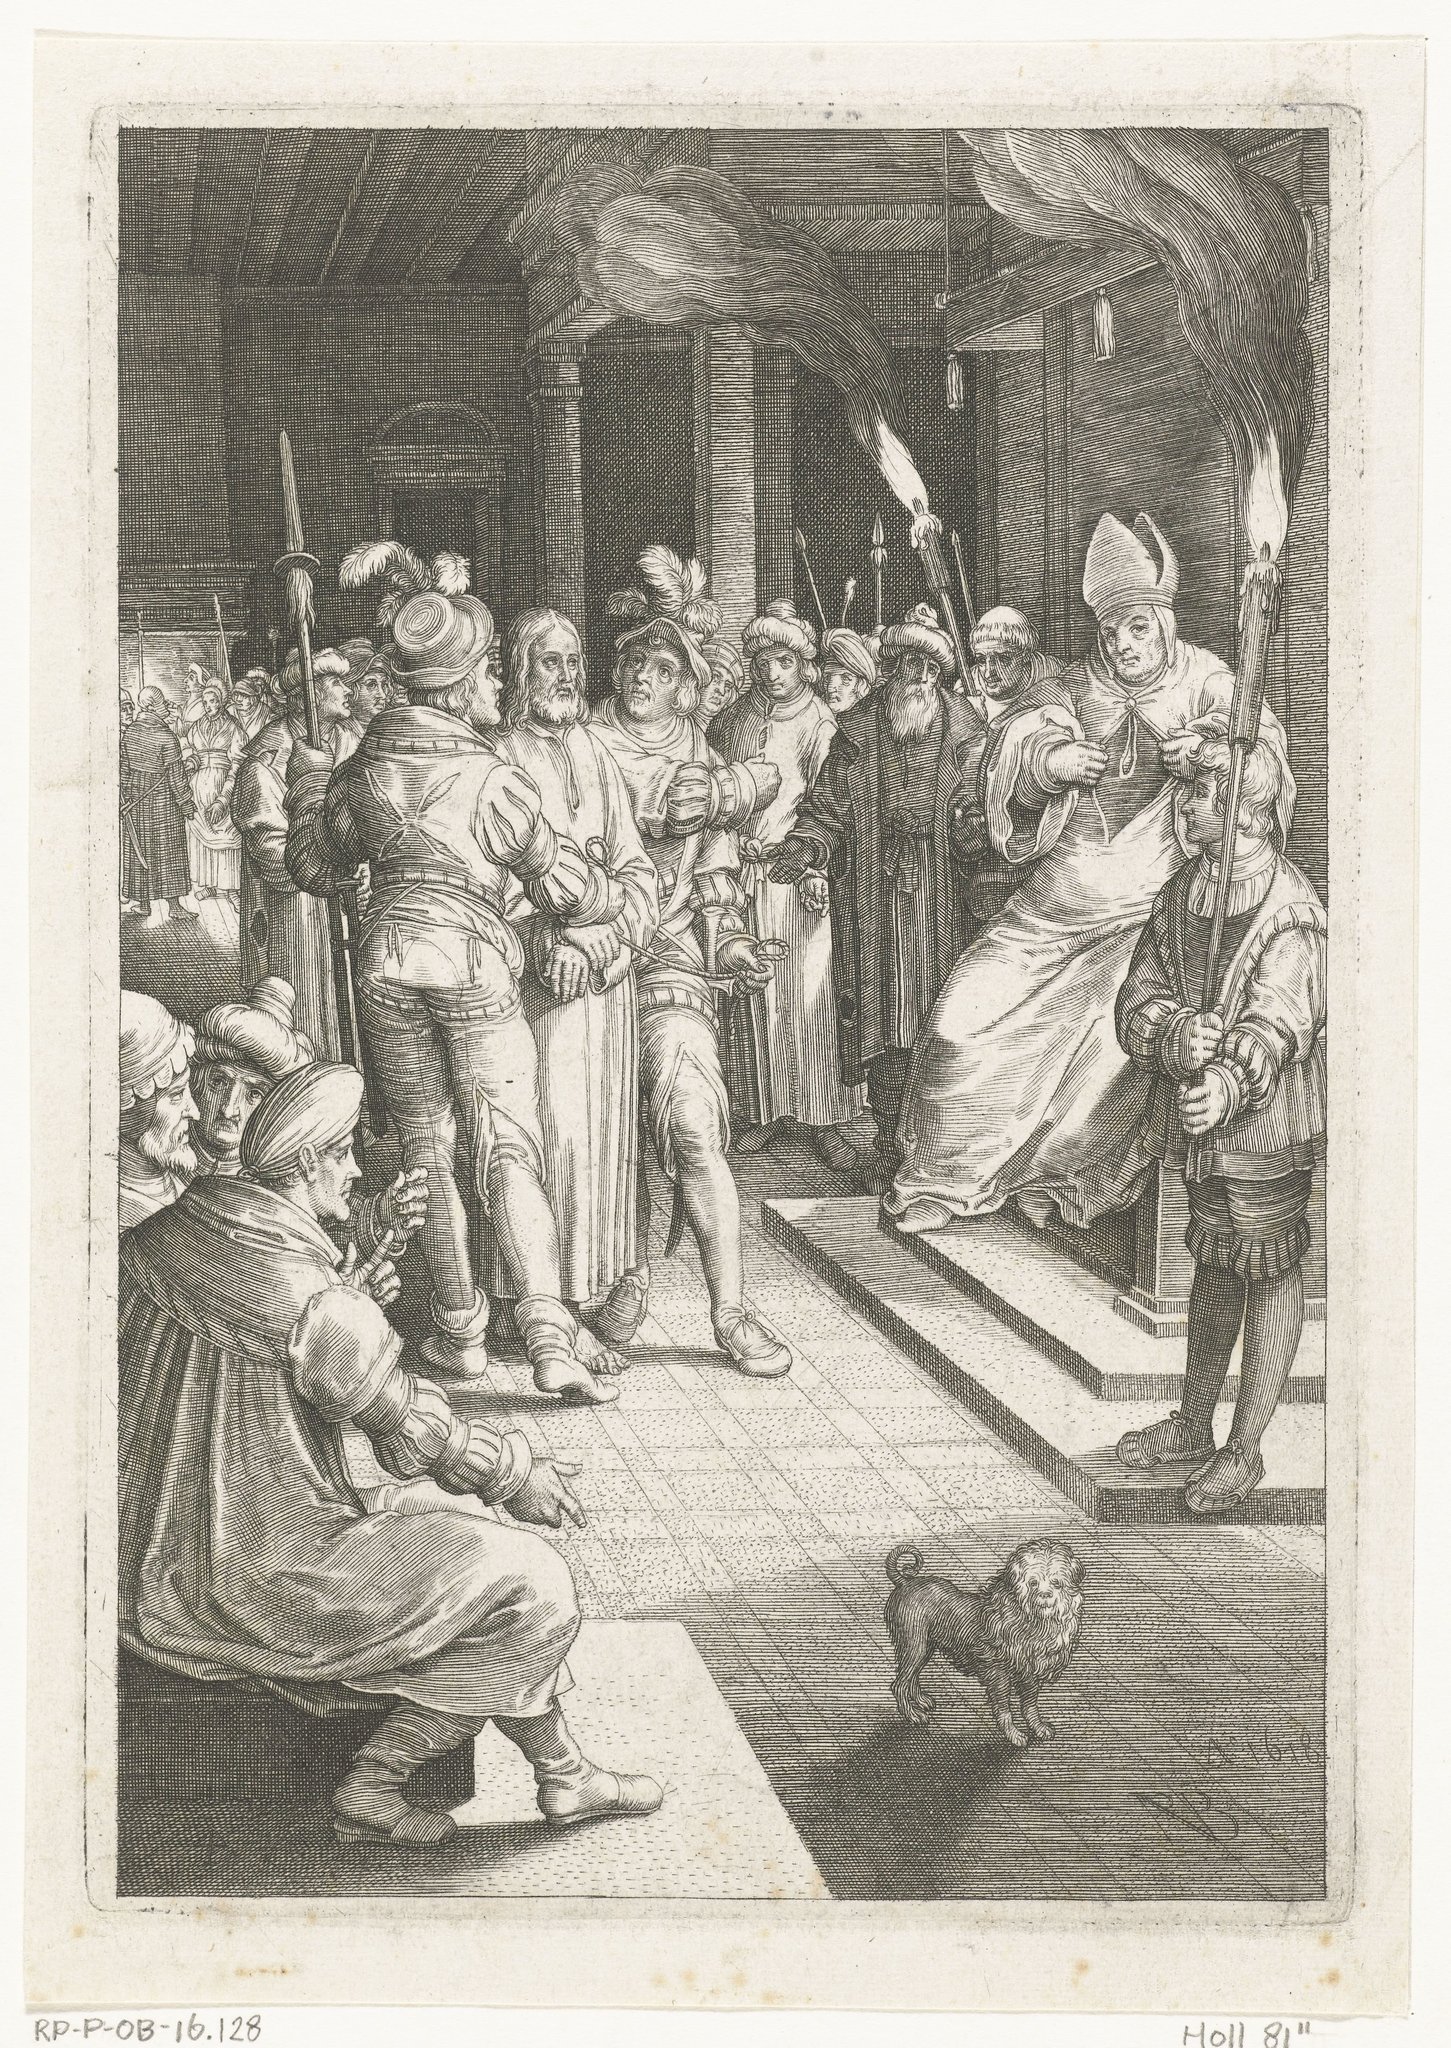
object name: print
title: De Passie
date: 1618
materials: paper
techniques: engraving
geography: netherlands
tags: christ before the sanhedrin with caiaphas as high priest, and possibly annas; maybe a soldier about to strike christ because he keeps silent (matthew 26:57-66; mark 14:53-64; luke 22:54, 22:66-71)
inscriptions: collector's mark: Lugt 2228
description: Christus wordt door soldaten voor de hogepriester Kajafas geleid. De priester zit op een troon en scheurt zijn kleding terwijl hij Christus beschuldigt van godslastering.